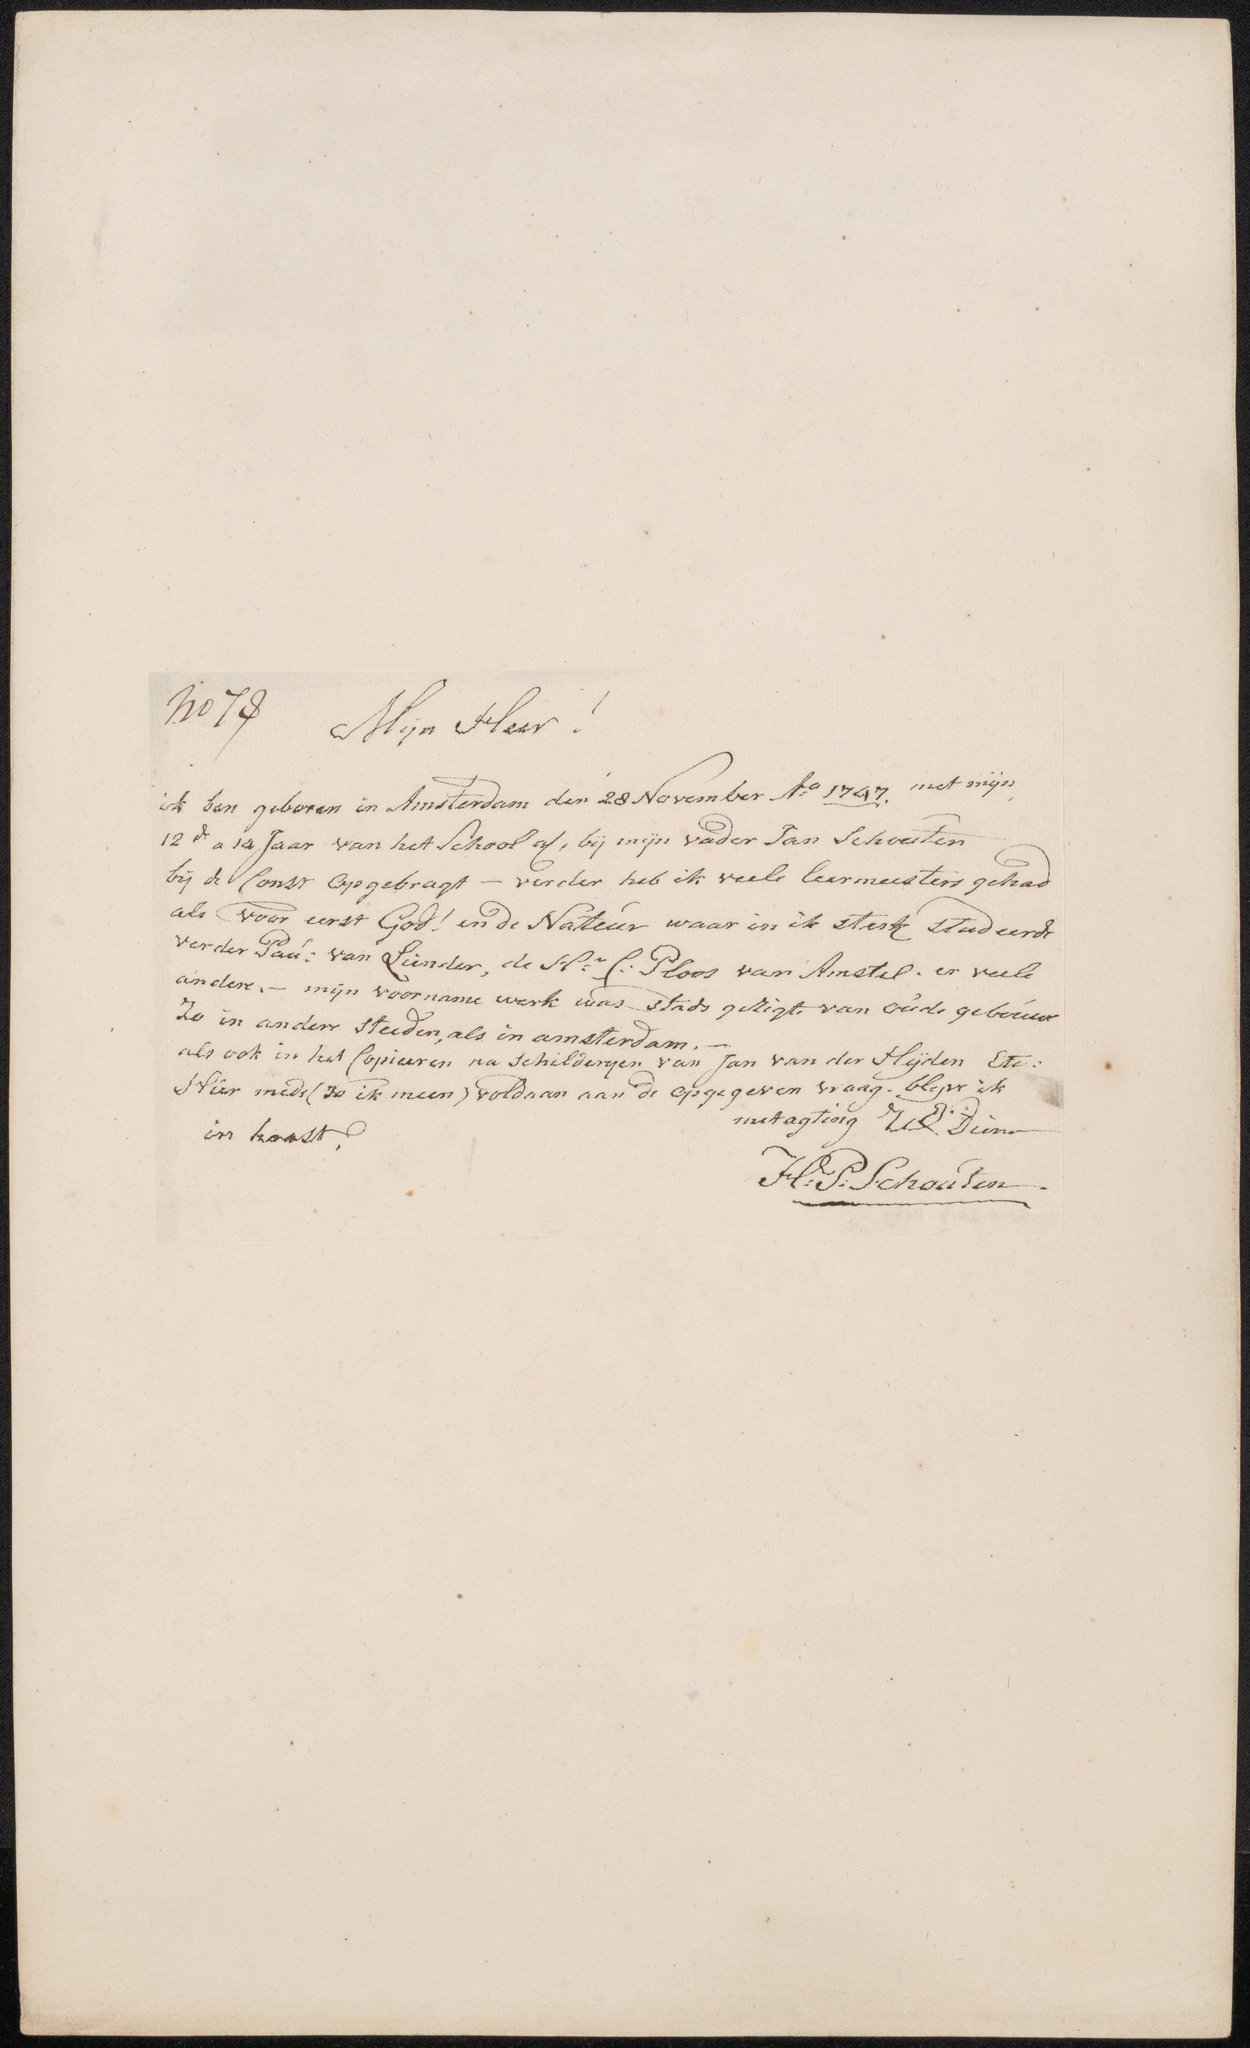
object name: letter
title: Brief aan anoniem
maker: hermanus petrus schouten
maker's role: draughtsman, painter, print maker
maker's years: 1747-1822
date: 1757-1822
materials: ink, paper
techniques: pen, writing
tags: utrecht, paulus van liender, jan van der heyden, cornelis ploos van amstel, silversmith, johannes schouten, education, tuition of the artist (in general), painting (including book-illumination, miniature-painting)